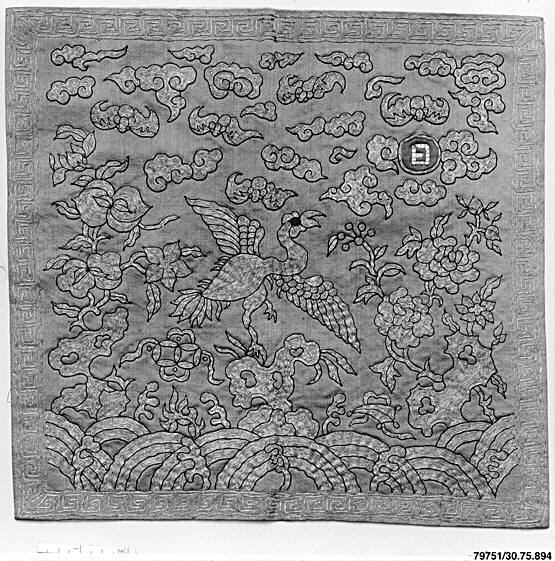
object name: rank badge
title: Rank Badge with Crane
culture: chinese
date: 1701-1800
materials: metal thread, silk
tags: bats,cranes